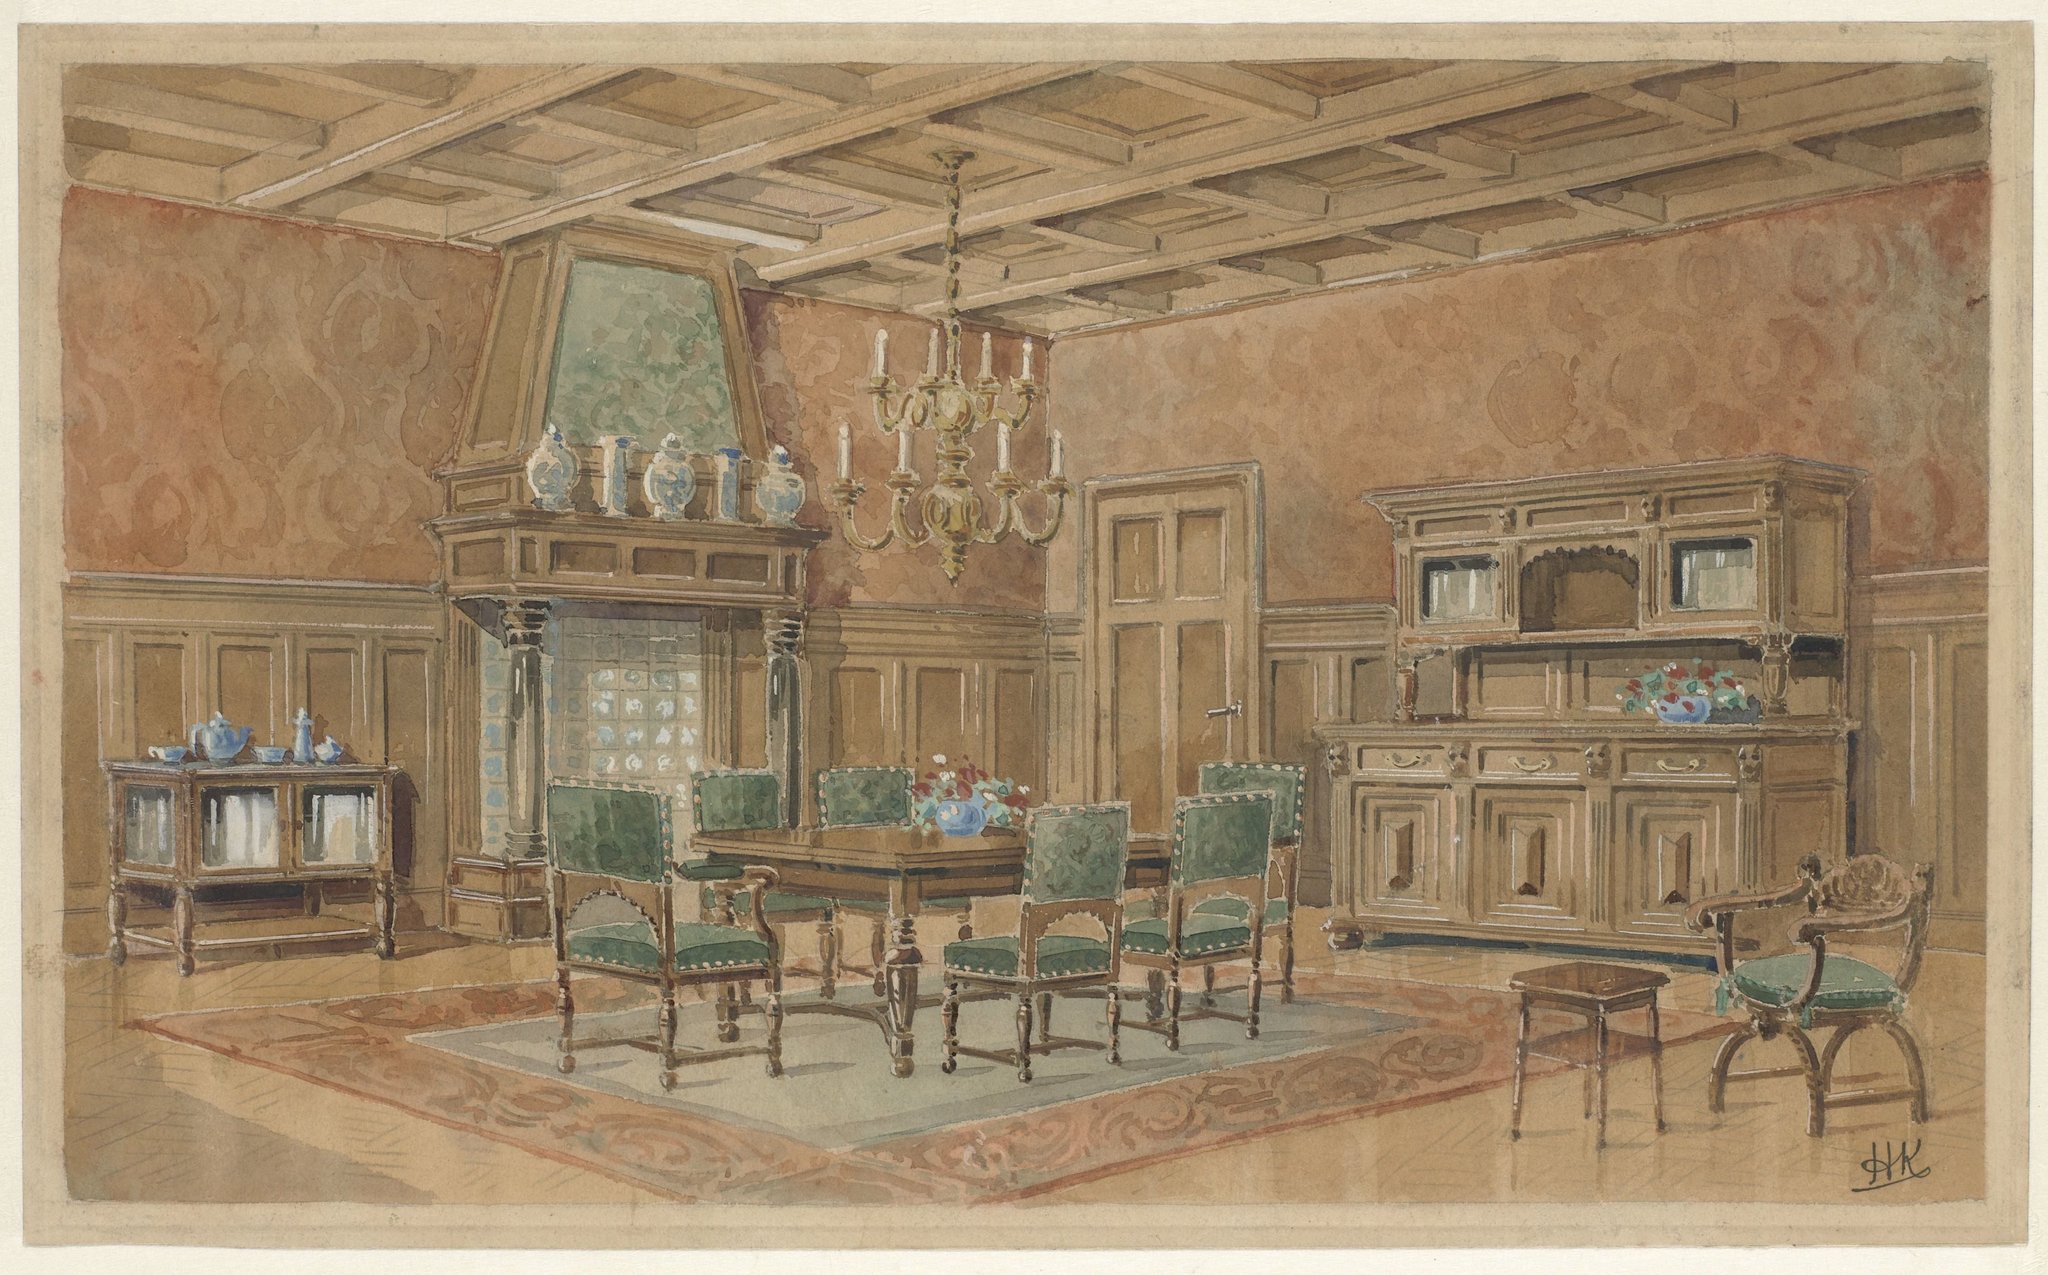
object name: drawing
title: Eetkamer met schouw in renaissance-stijl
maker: monogrammist hk (nederland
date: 1925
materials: paper, watercolor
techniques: brush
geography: amsterdam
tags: communal rooms, dining-room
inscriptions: monogram: ‘HK’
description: Mogelijk is dit een demonstratietekeningen van een meubel- of inrichtingszaak.